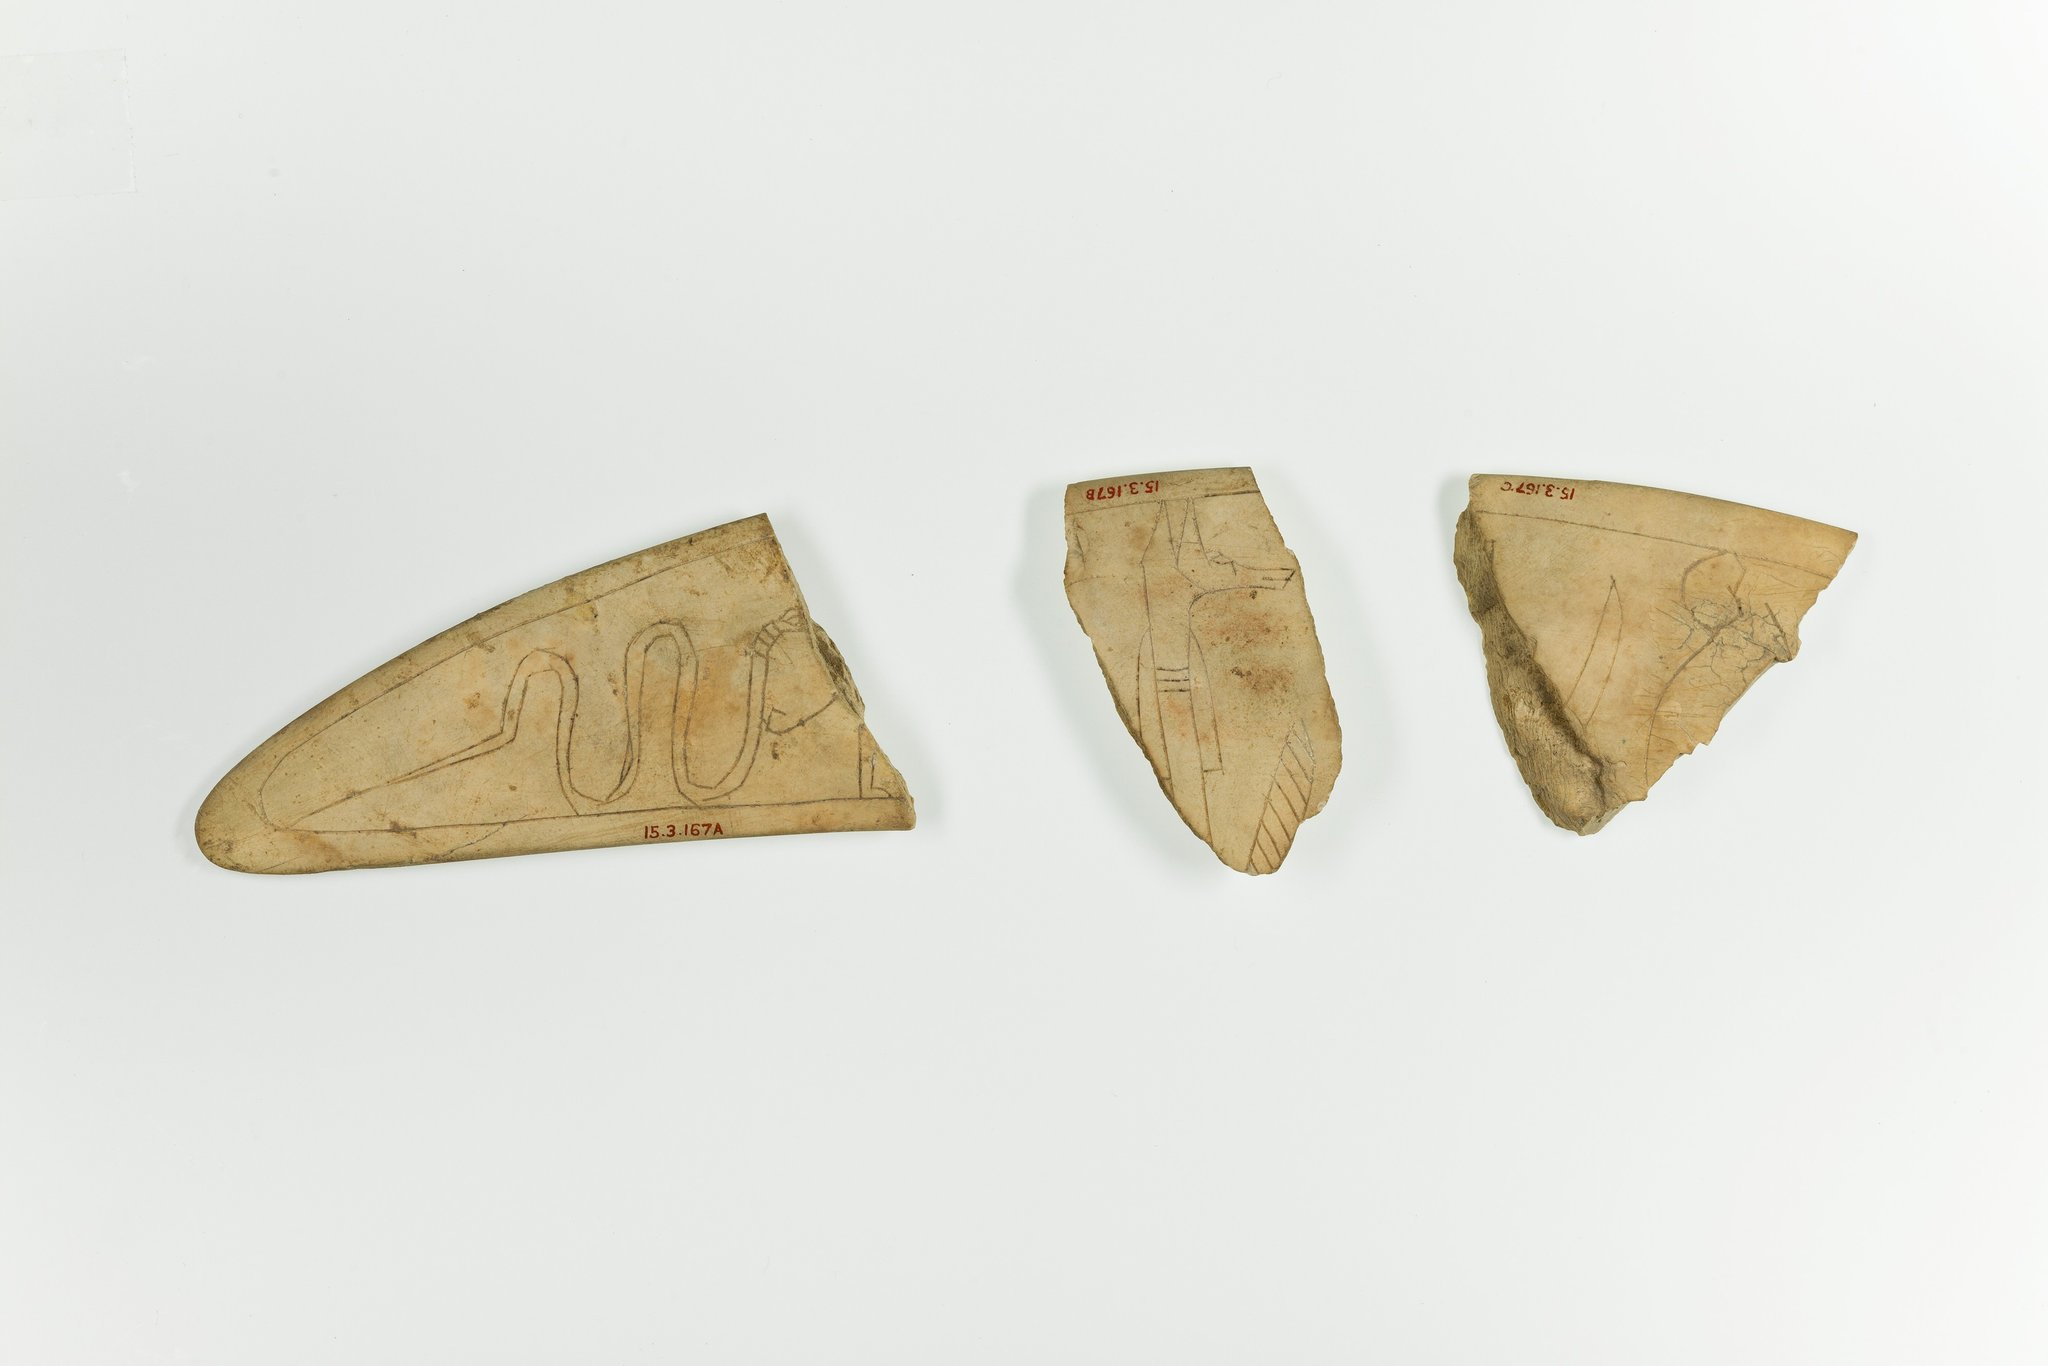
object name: magic knife fragment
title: Magic knife fragments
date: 1750-1640 BCE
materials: ivory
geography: egypt